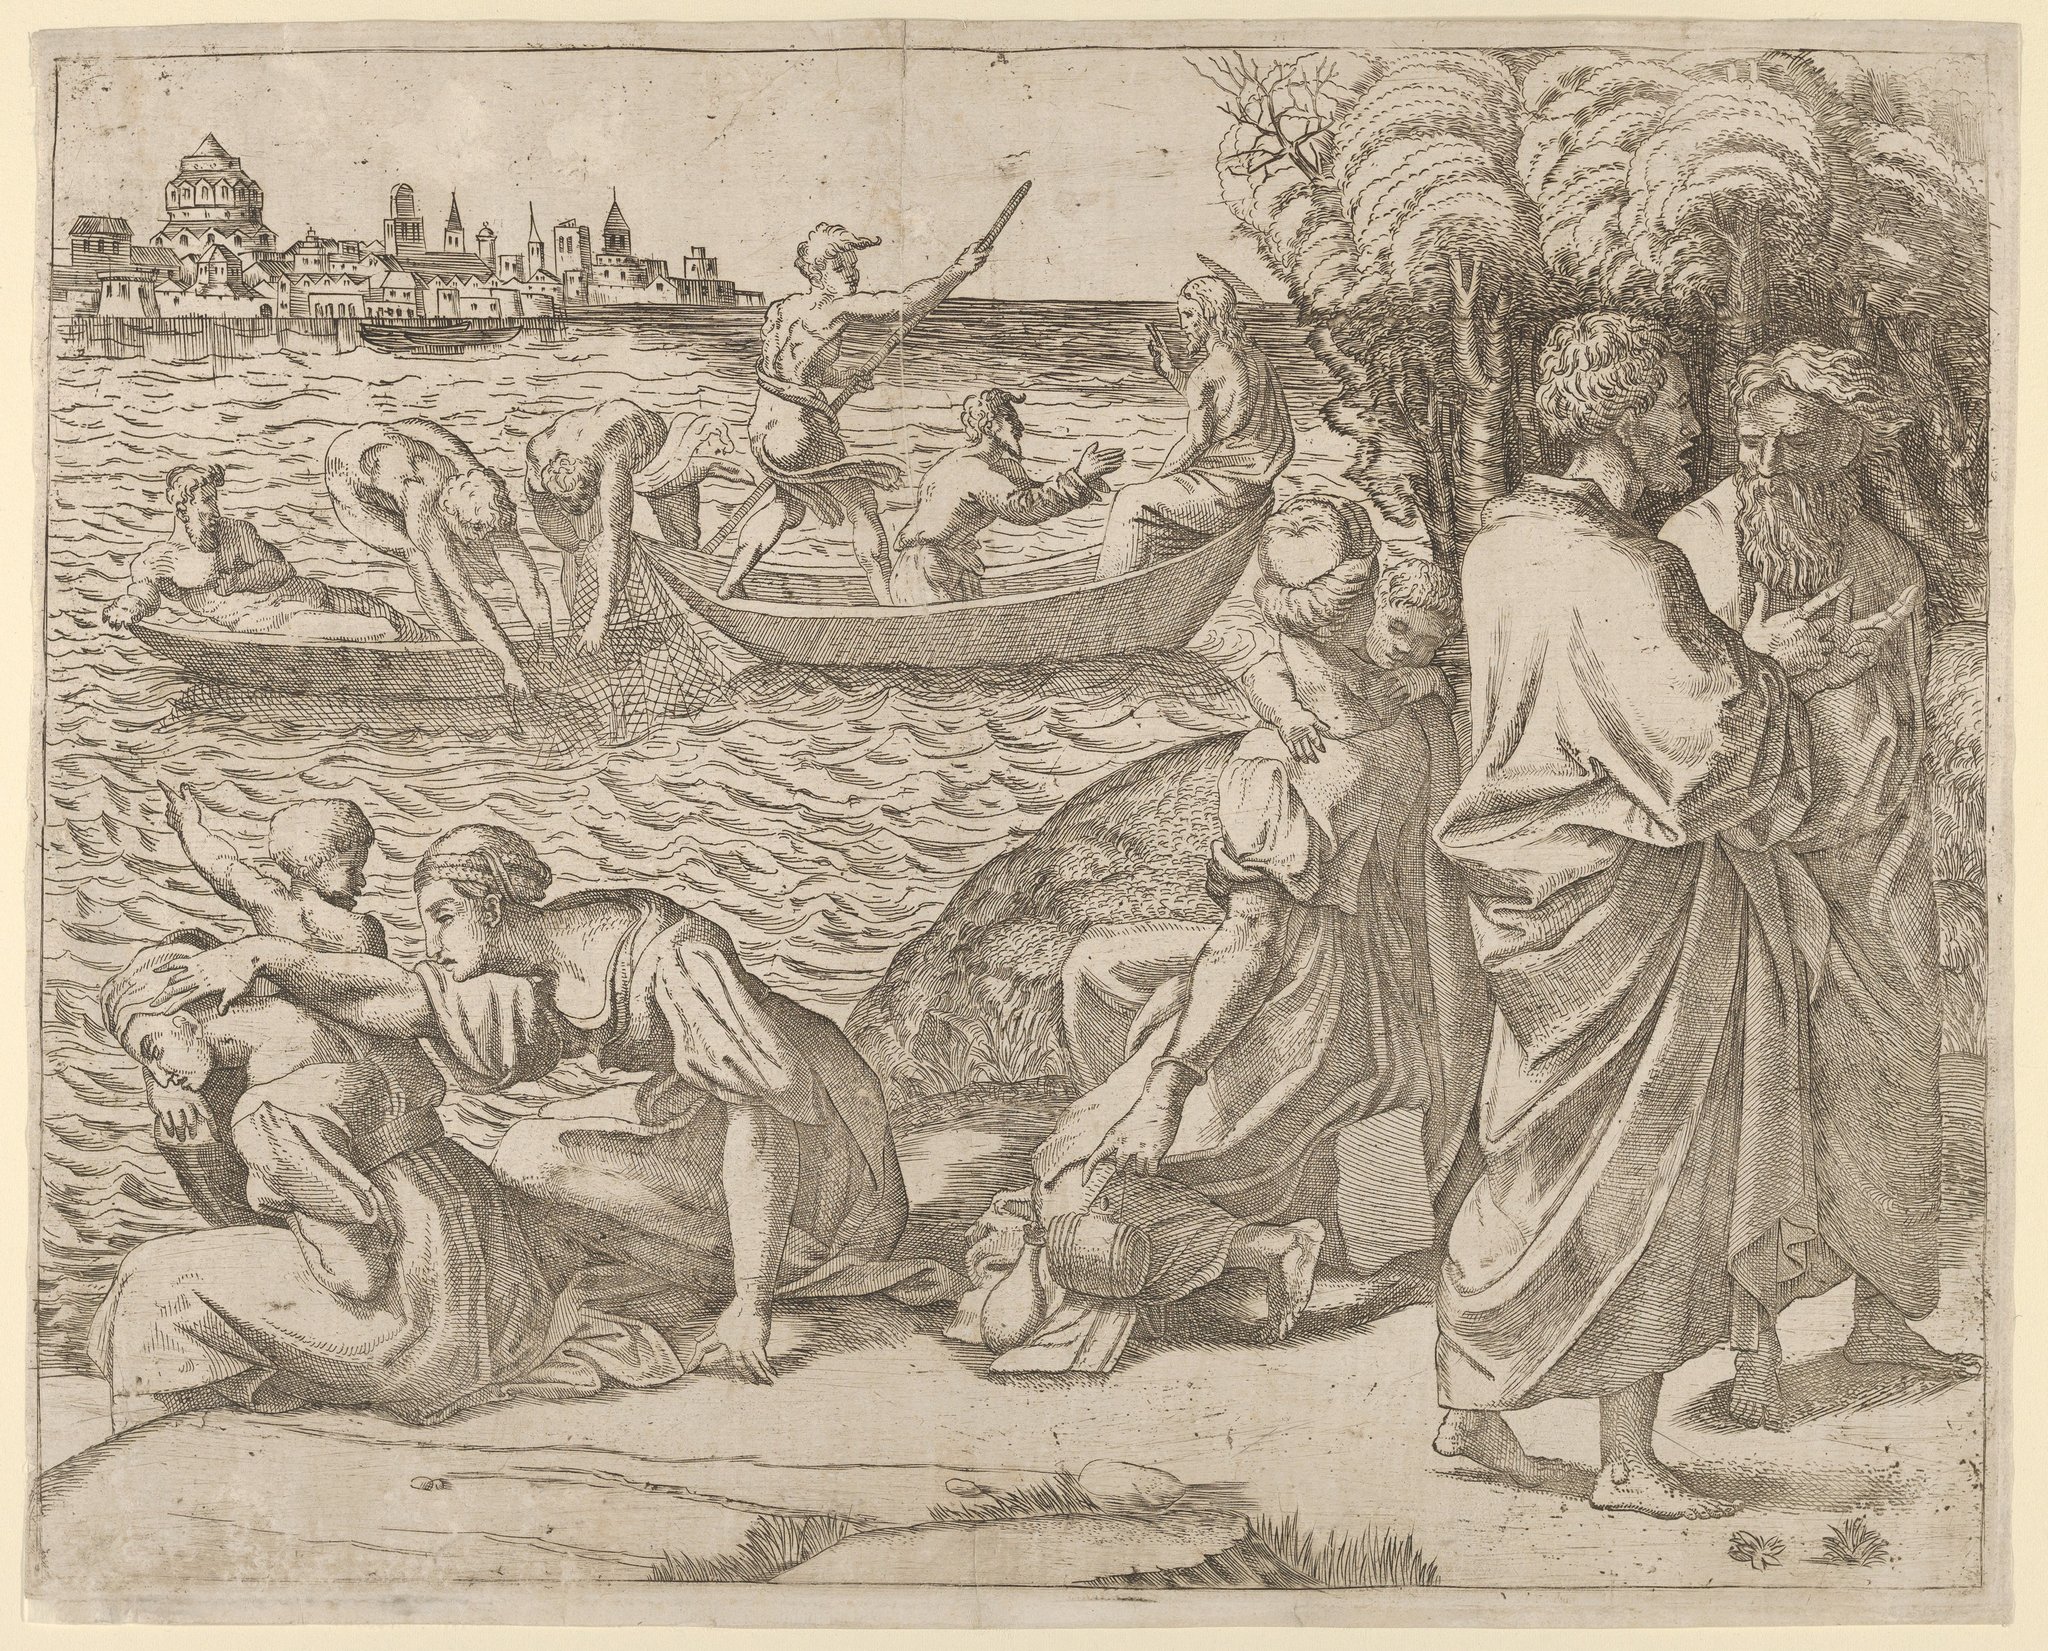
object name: print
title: The Miraculous Draught of Fishes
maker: anonymous, french, school of fontainebleau, 16th century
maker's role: artist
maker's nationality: french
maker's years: 1500-1600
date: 1540-1550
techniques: etching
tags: men,women,fishing,boats